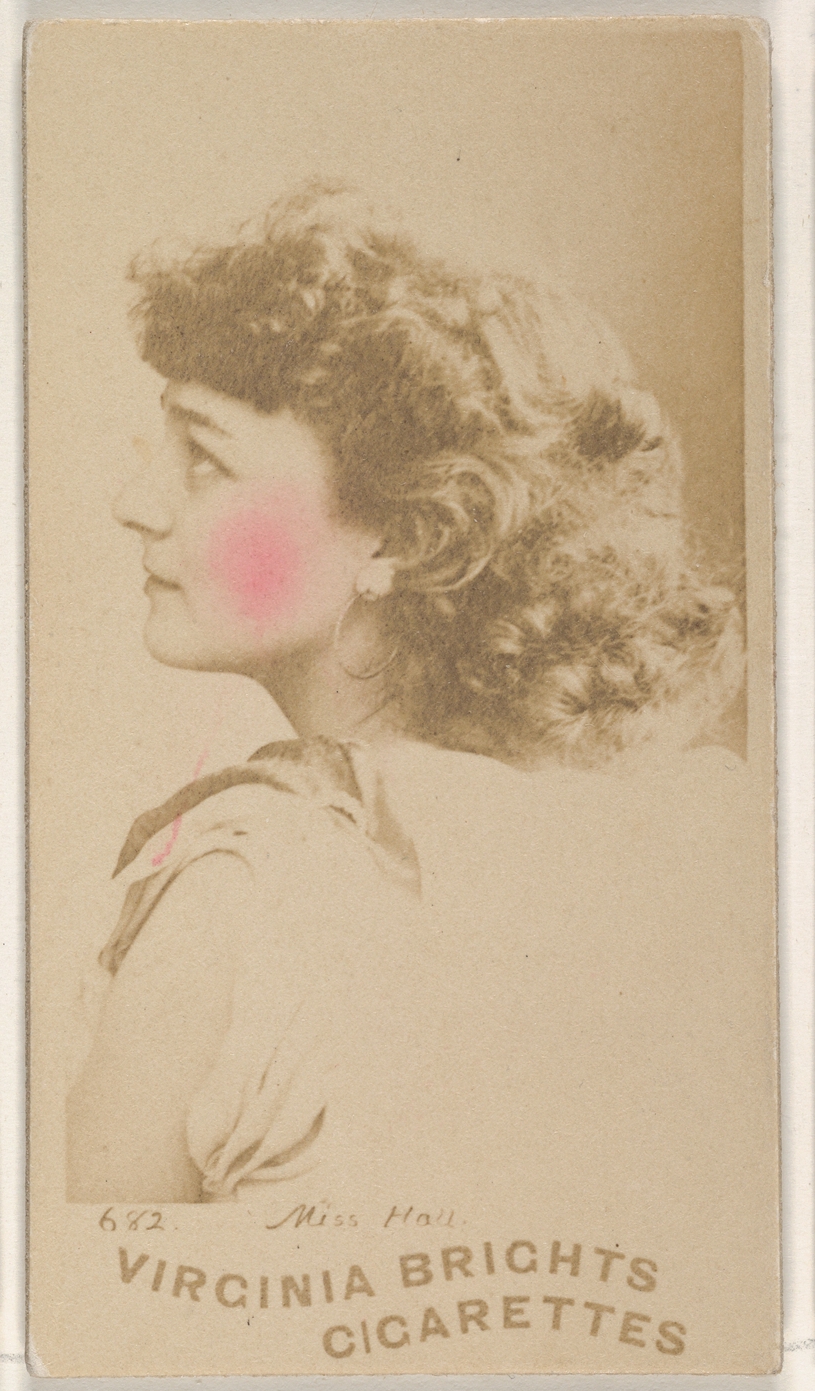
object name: photograph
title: Card 682, Miss Hall, from the Actors and Actresses series (N45, Type 1) for Virginia Brights Cigarettes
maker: allen & ginter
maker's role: publisher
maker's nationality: american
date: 1888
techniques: albumen silver print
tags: portraits,profiles,women,actresses